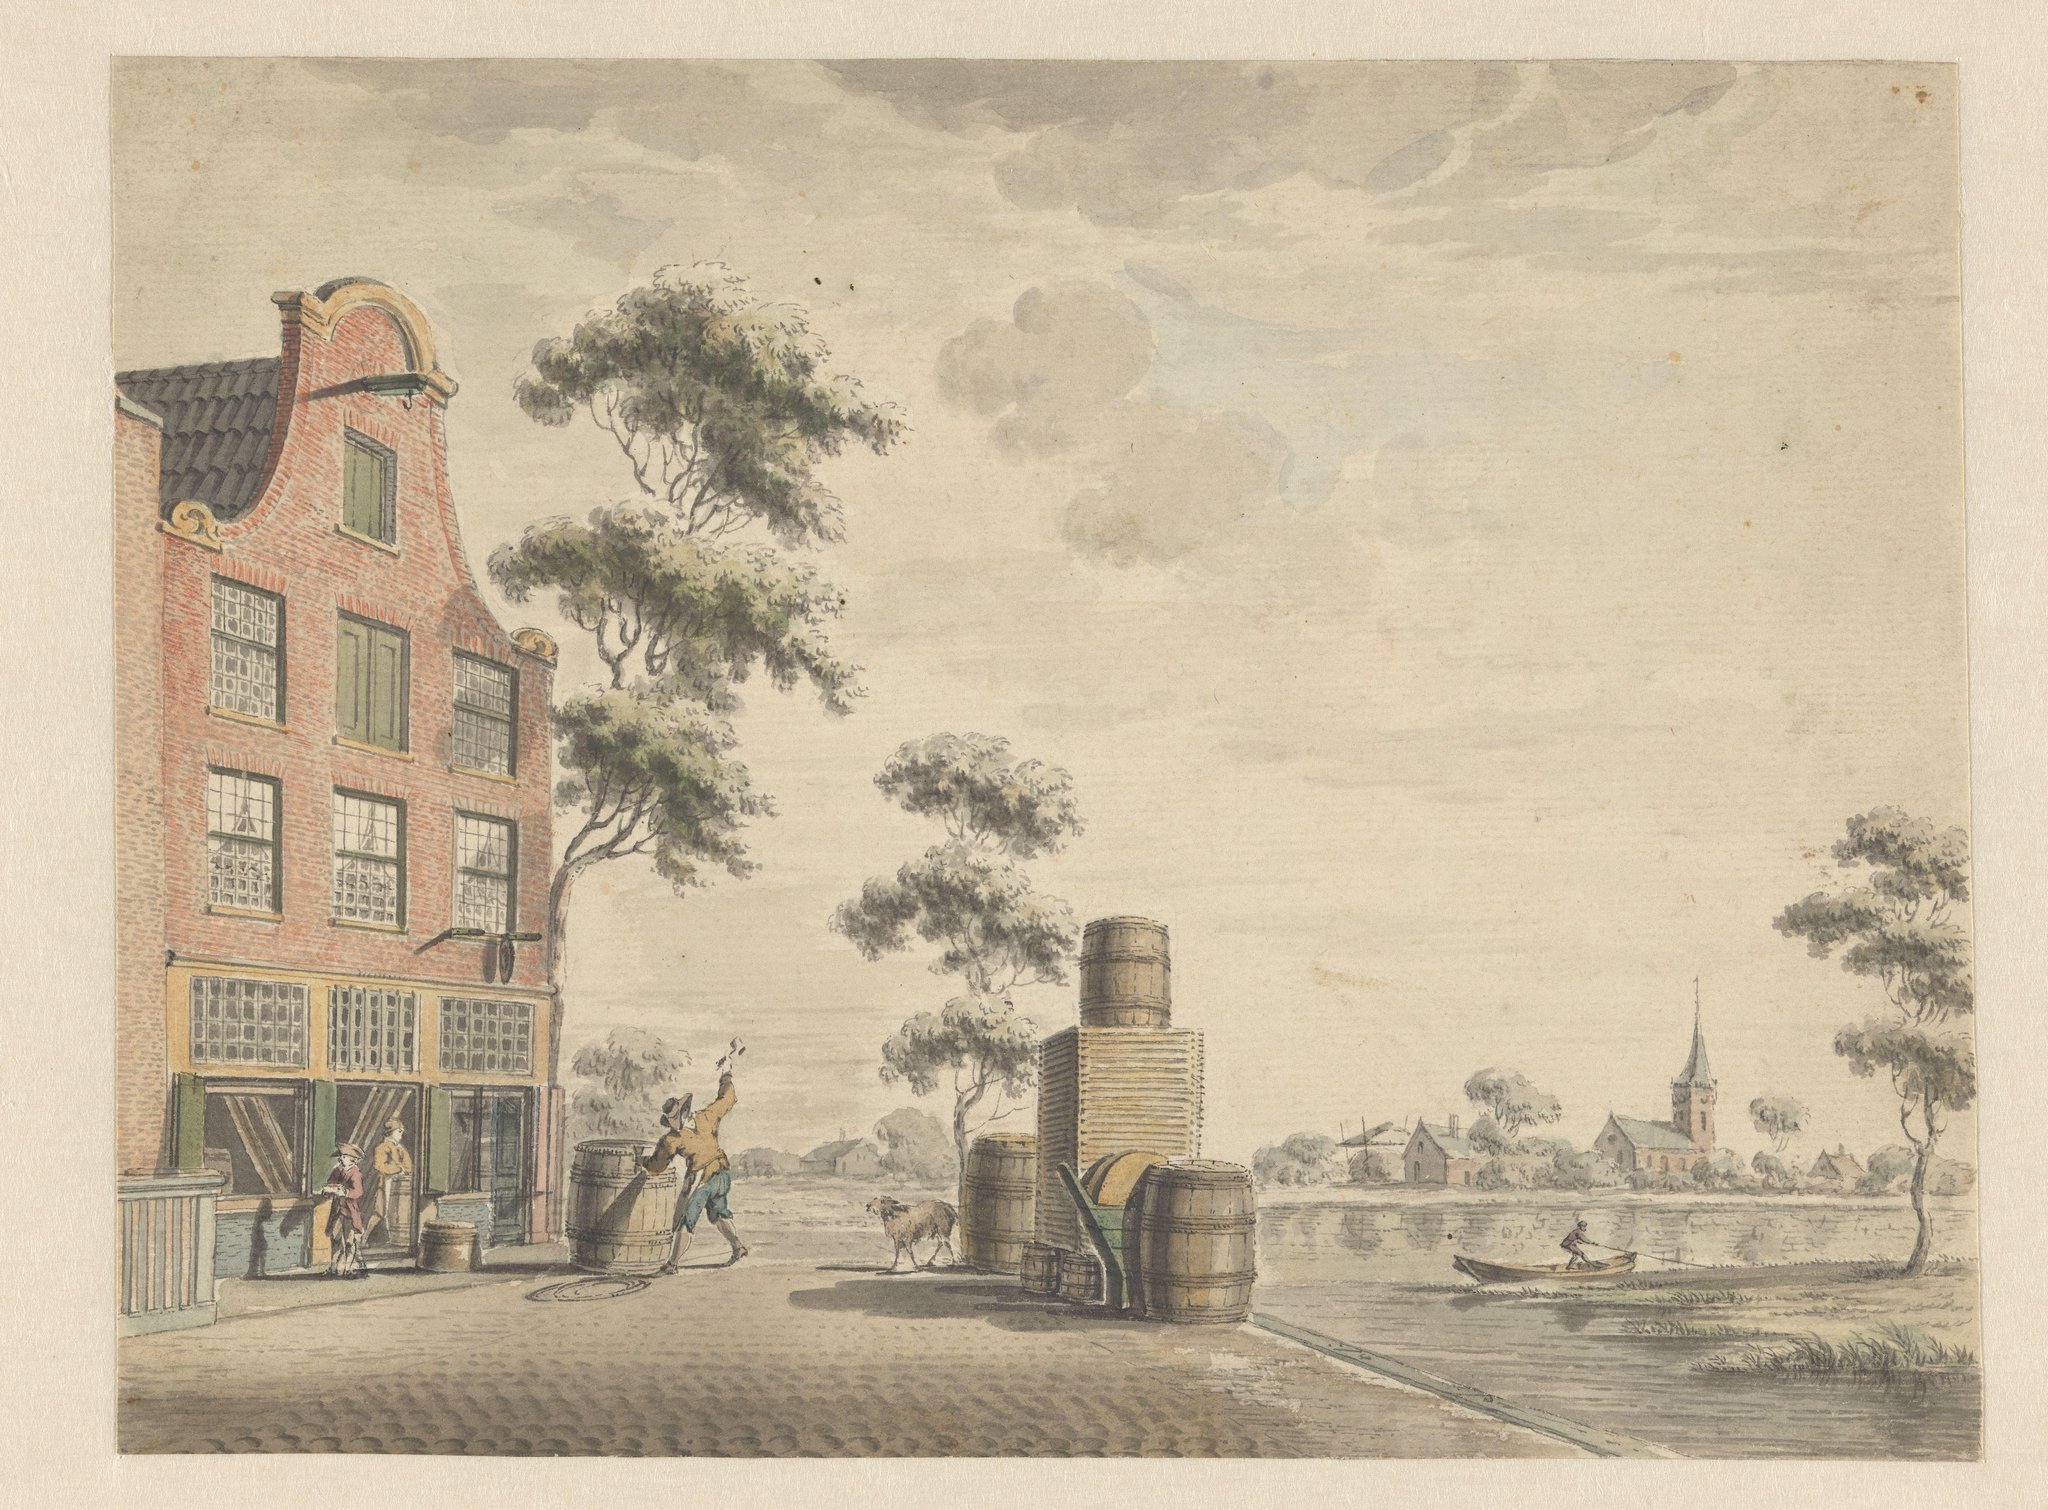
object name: drawing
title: Een kuiper voor zijn huis aan het werk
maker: Anonymous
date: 1700-1800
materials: ink, paper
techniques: brush, pen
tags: wooden container: barrel, cask, bucket, other handicrafts ~ wood